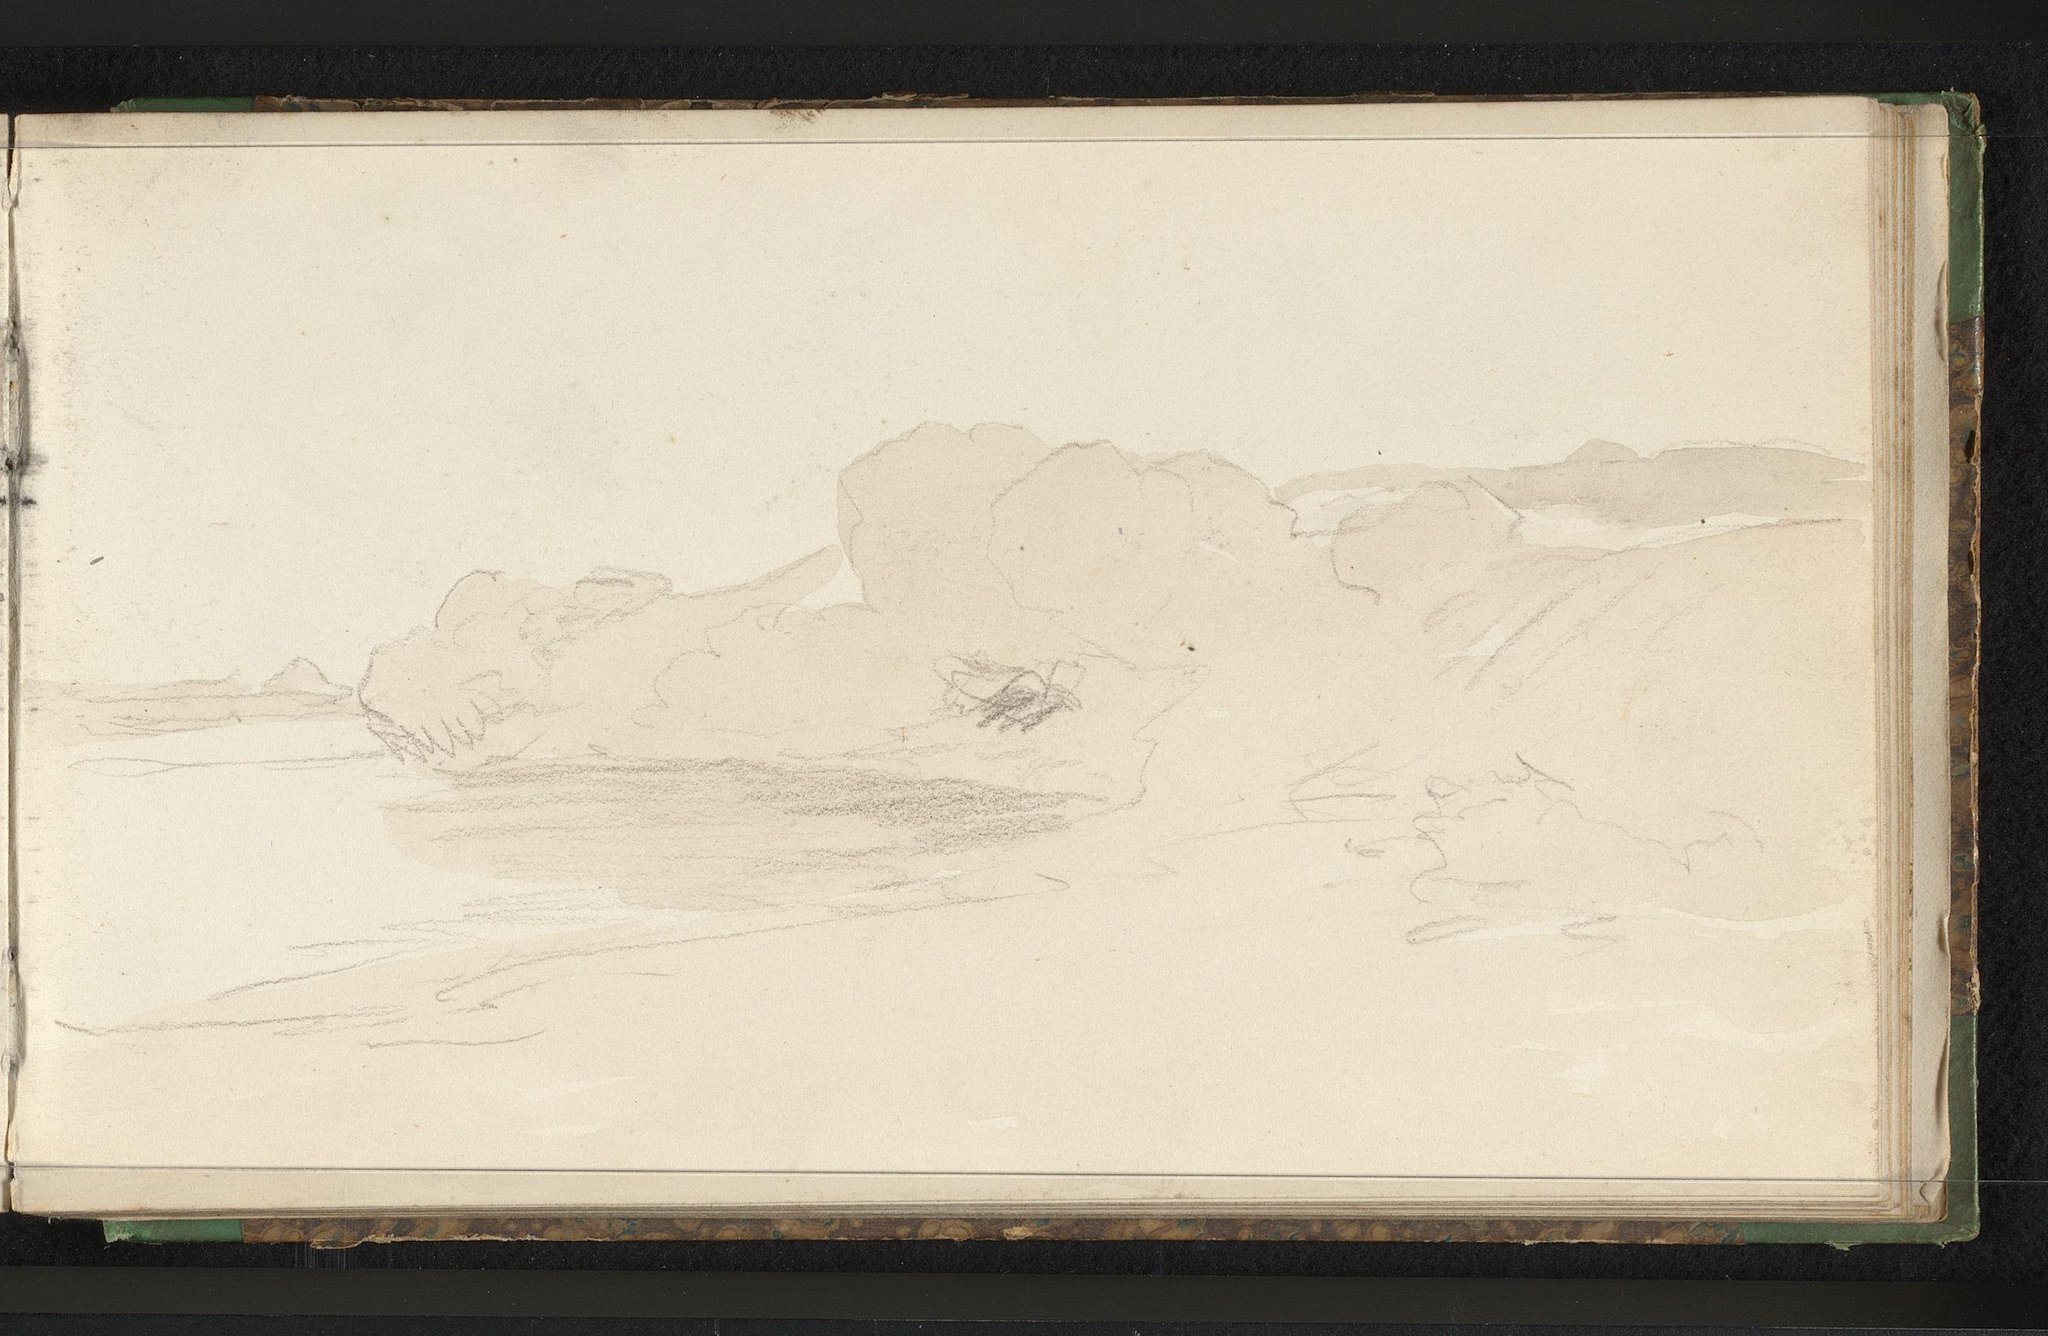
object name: sketchbook leaf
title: Landschap met water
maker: jan bedijs tom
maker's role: draughtsman, painter, print maker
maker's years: 1813-1894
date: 1828-1894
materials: paper, pencil, watercolor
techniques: brush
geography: the hague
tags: landscapes, landscapes with waters, waterscapes, seascapes (in the temperate zone), artist (in general) making preliminary designs, sketching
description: Pagina 45 verso uit een schetsboek met 50 bladen.